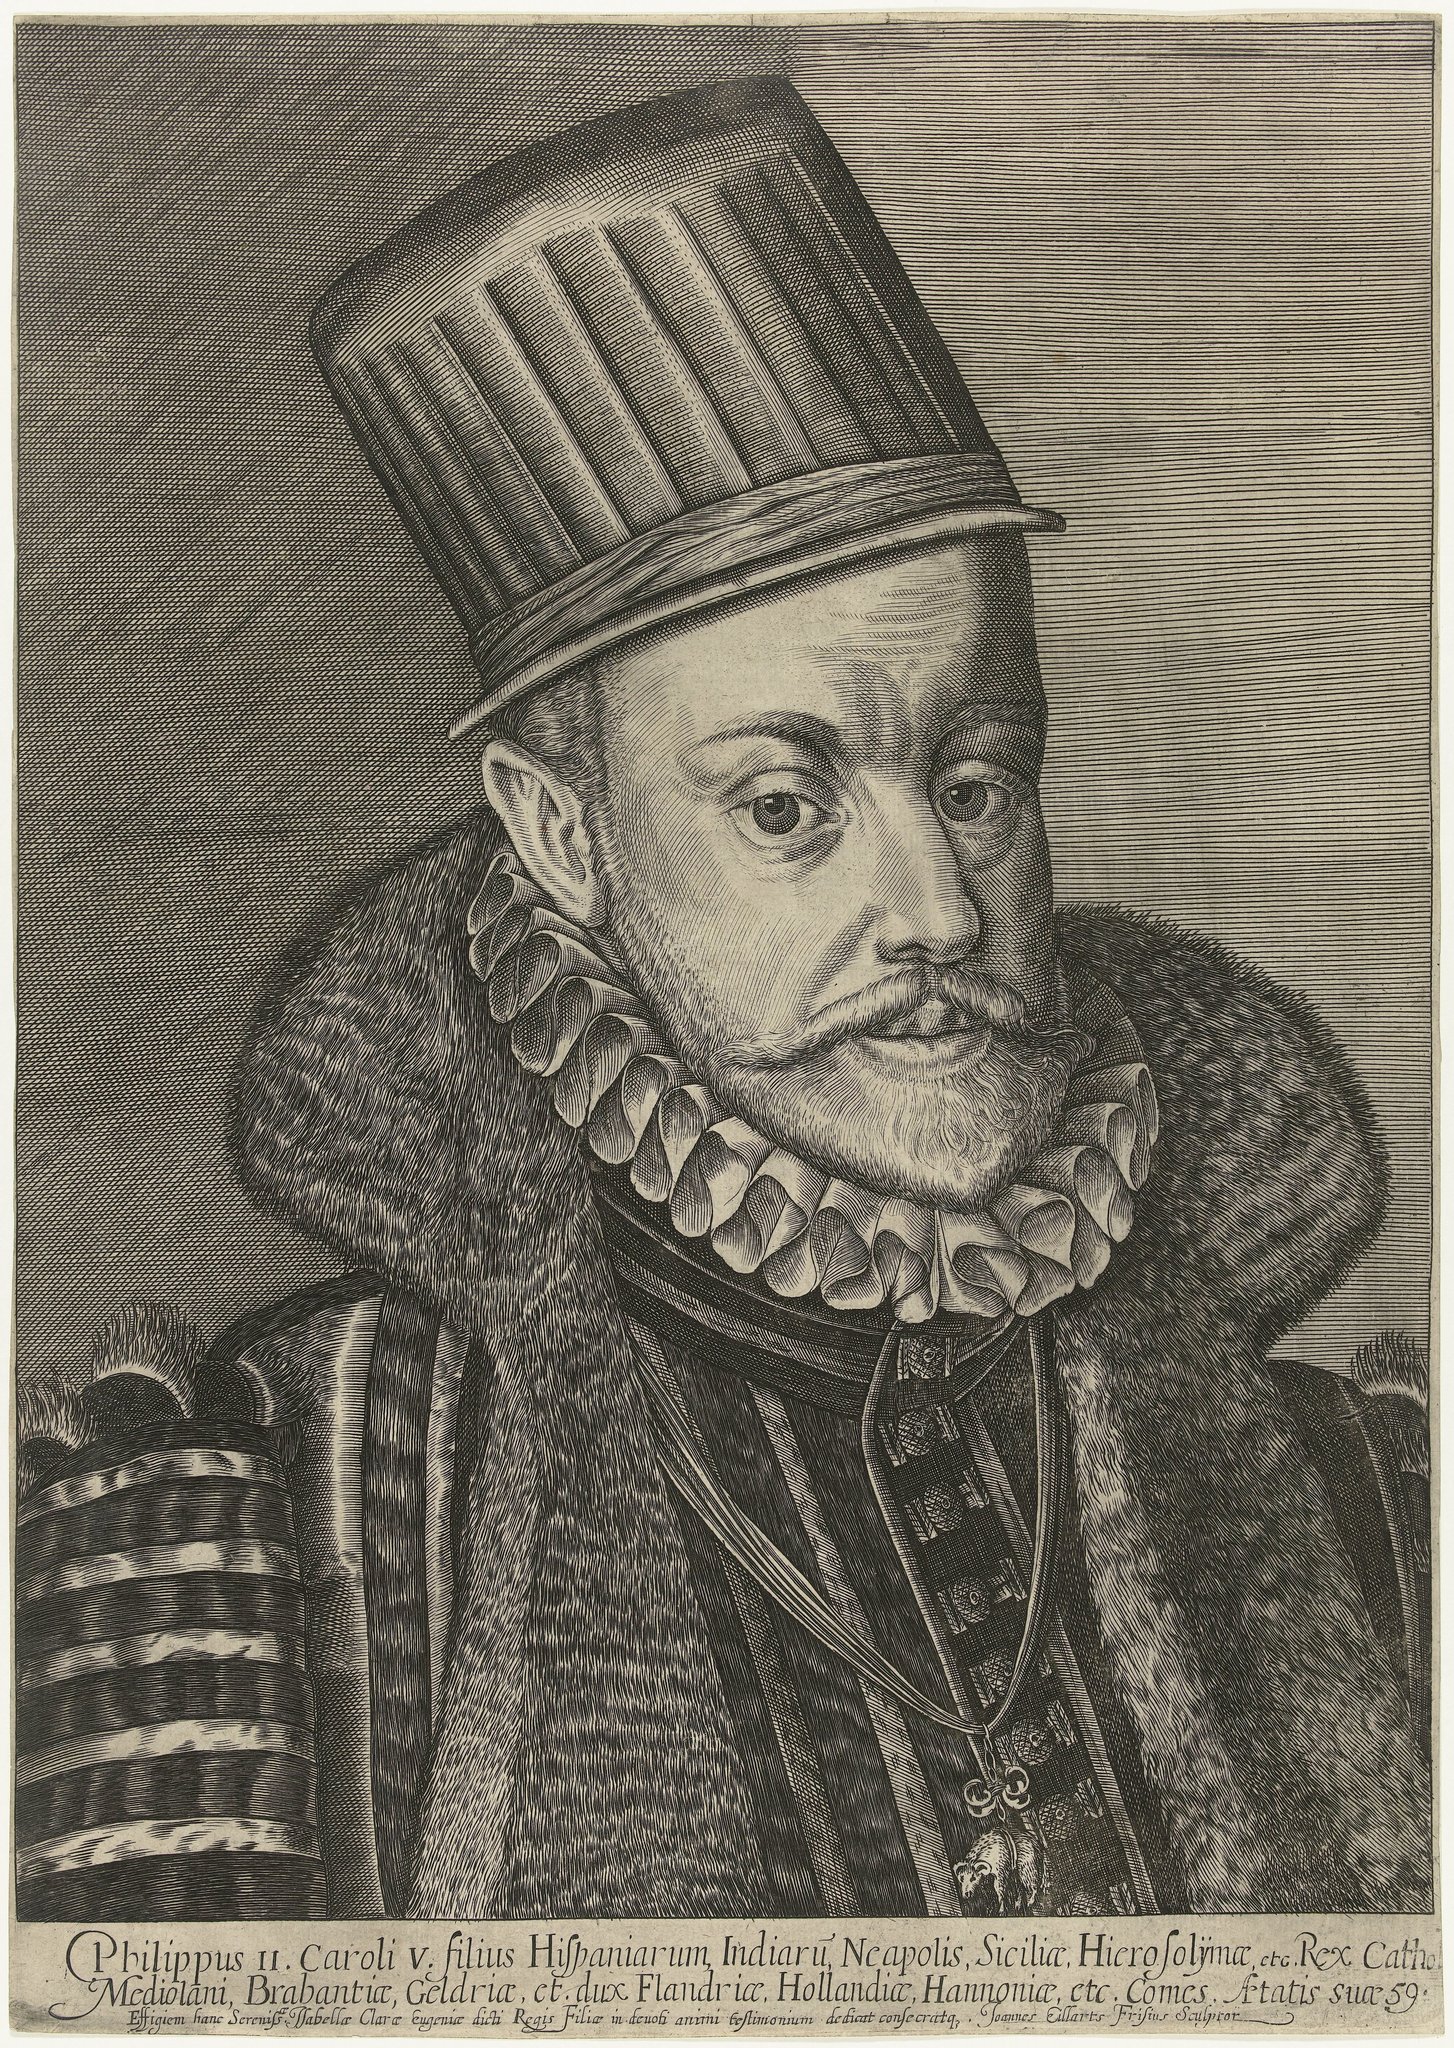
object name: print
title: Philips II van Spanje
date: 1600-1650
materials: paper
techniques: engraving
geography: leeuwarden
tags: philip ii of spain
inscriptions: collector's mark: Lugt 2228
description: Busteportret van Filips II van Spanje (1527-1598), koning van Spanje, Napels, Sicilië en Portugal en Heer der Nederlanden. Afgebeeld met hoge hoed, bontmantel en ketting met insigne van de Orde van het Gulden Vlies. Onder de voorstelling twee regels Latijn.